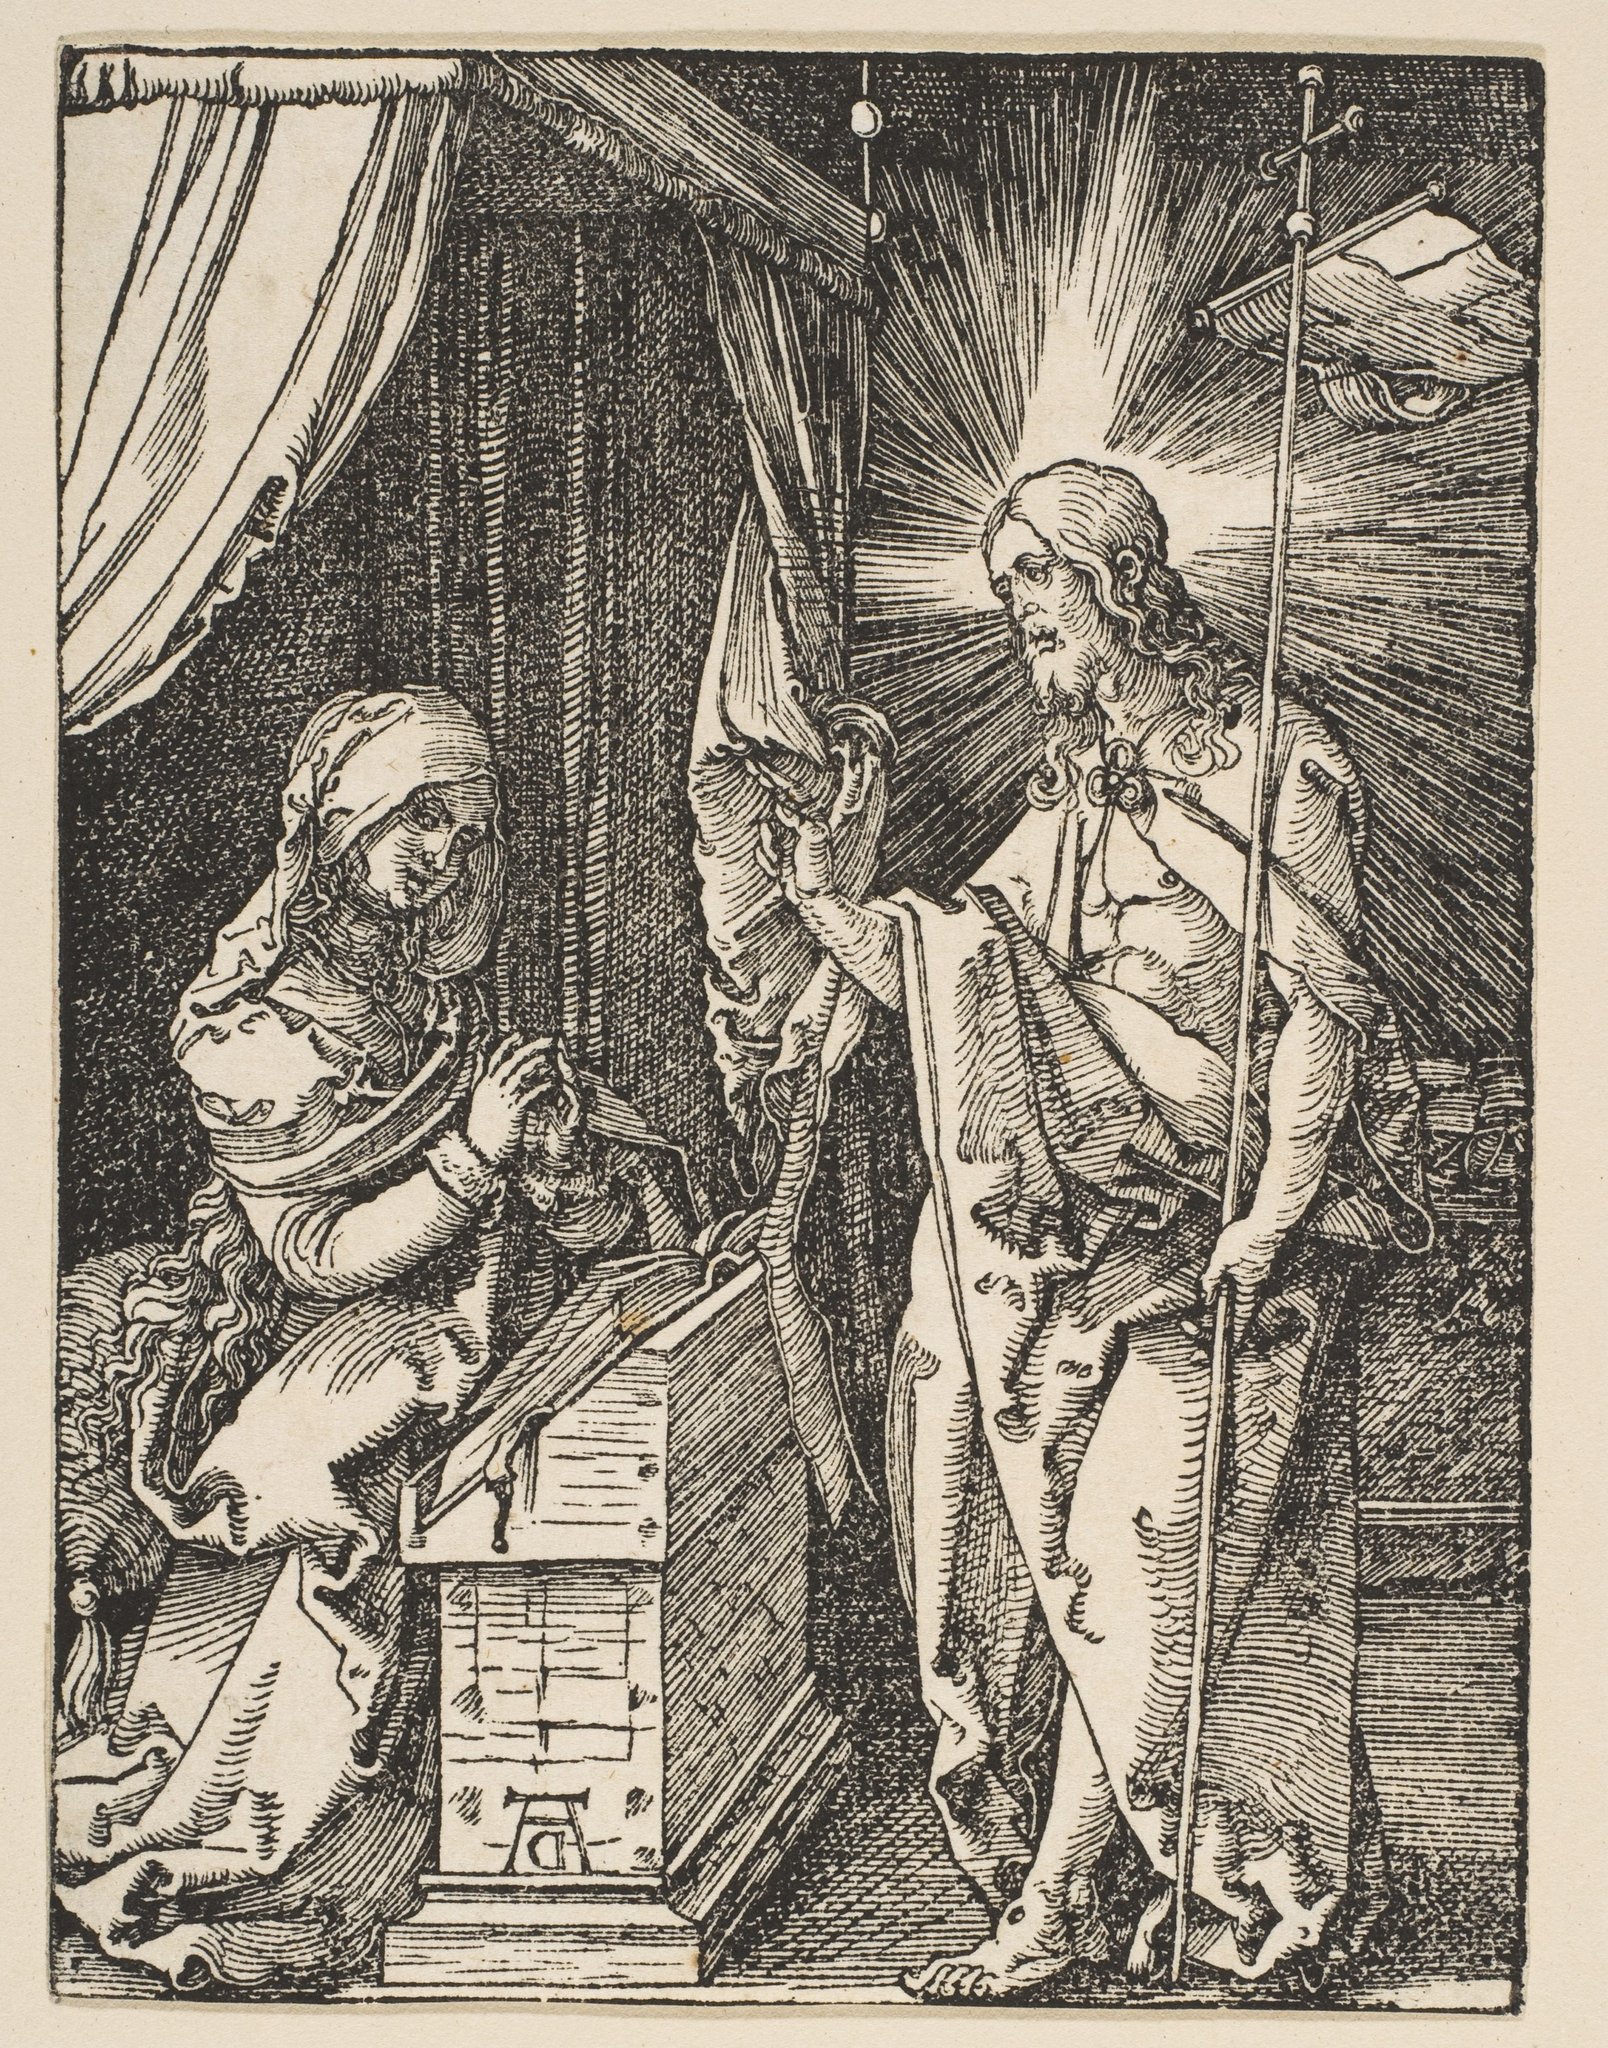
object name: print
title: Christ Appearing to His Mother, from "The Small Passion"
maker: albrecht dürer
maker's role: artist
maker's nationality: german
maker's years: 1471-1528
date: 1510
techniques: woodcut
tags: christ,virgin mary